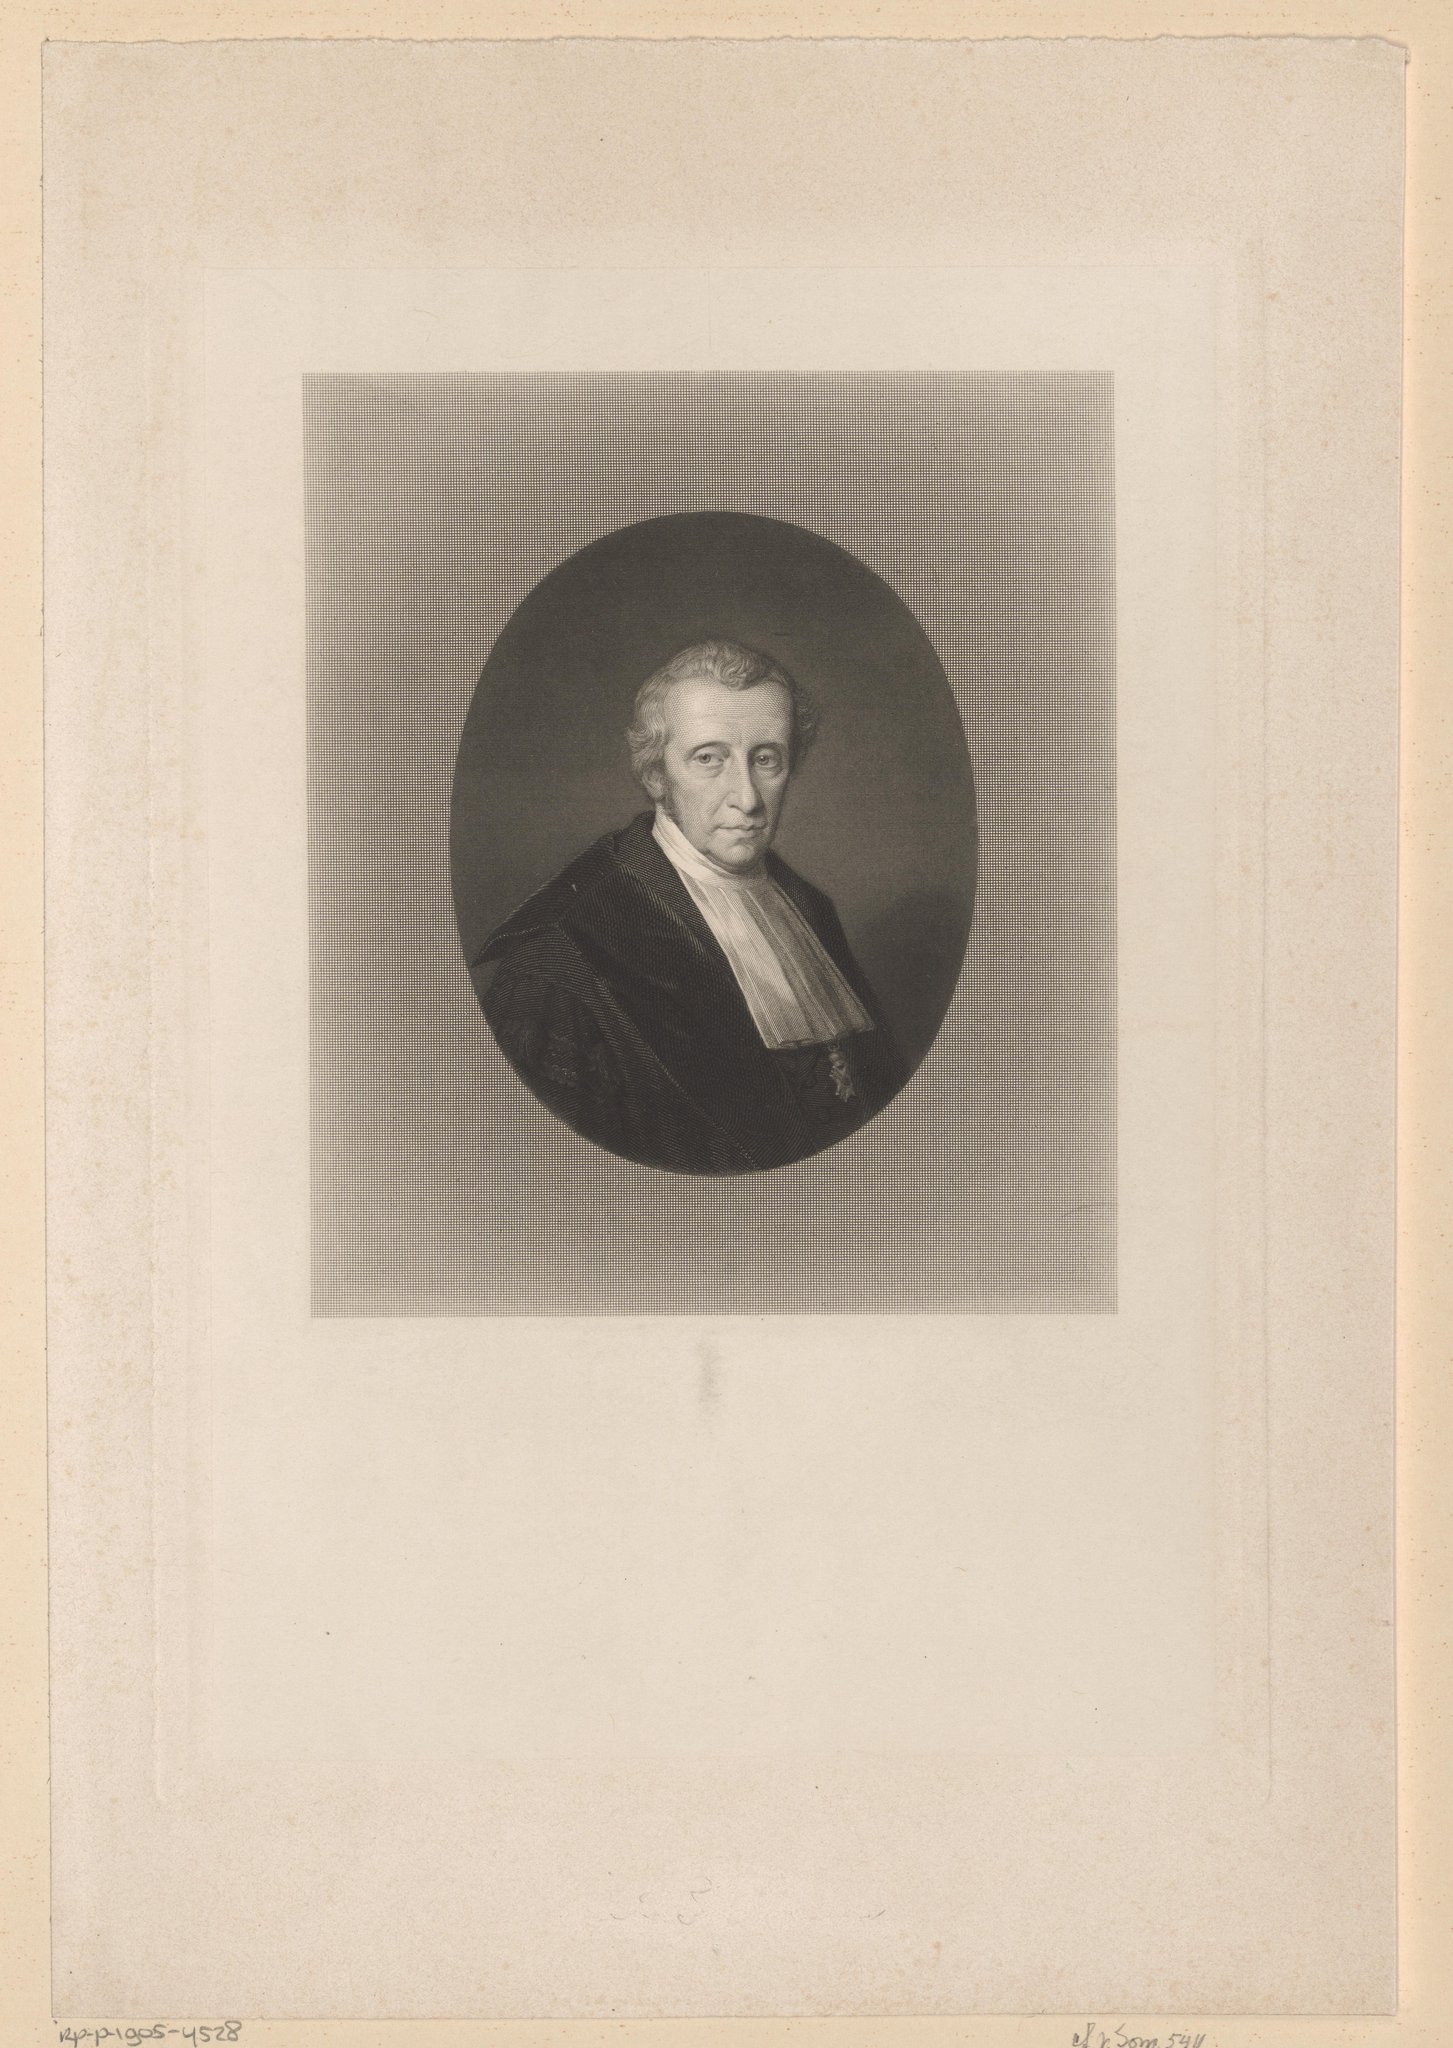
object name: print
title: Portret van Bernardus Franciscus Suerman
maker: willem frederik wehmeyer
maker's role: print maker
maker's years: 1819-1854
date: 1829-1854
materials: paper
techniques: engraving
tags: haarlem, historical persons, professor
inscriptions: collector's mark: Lugt 2228